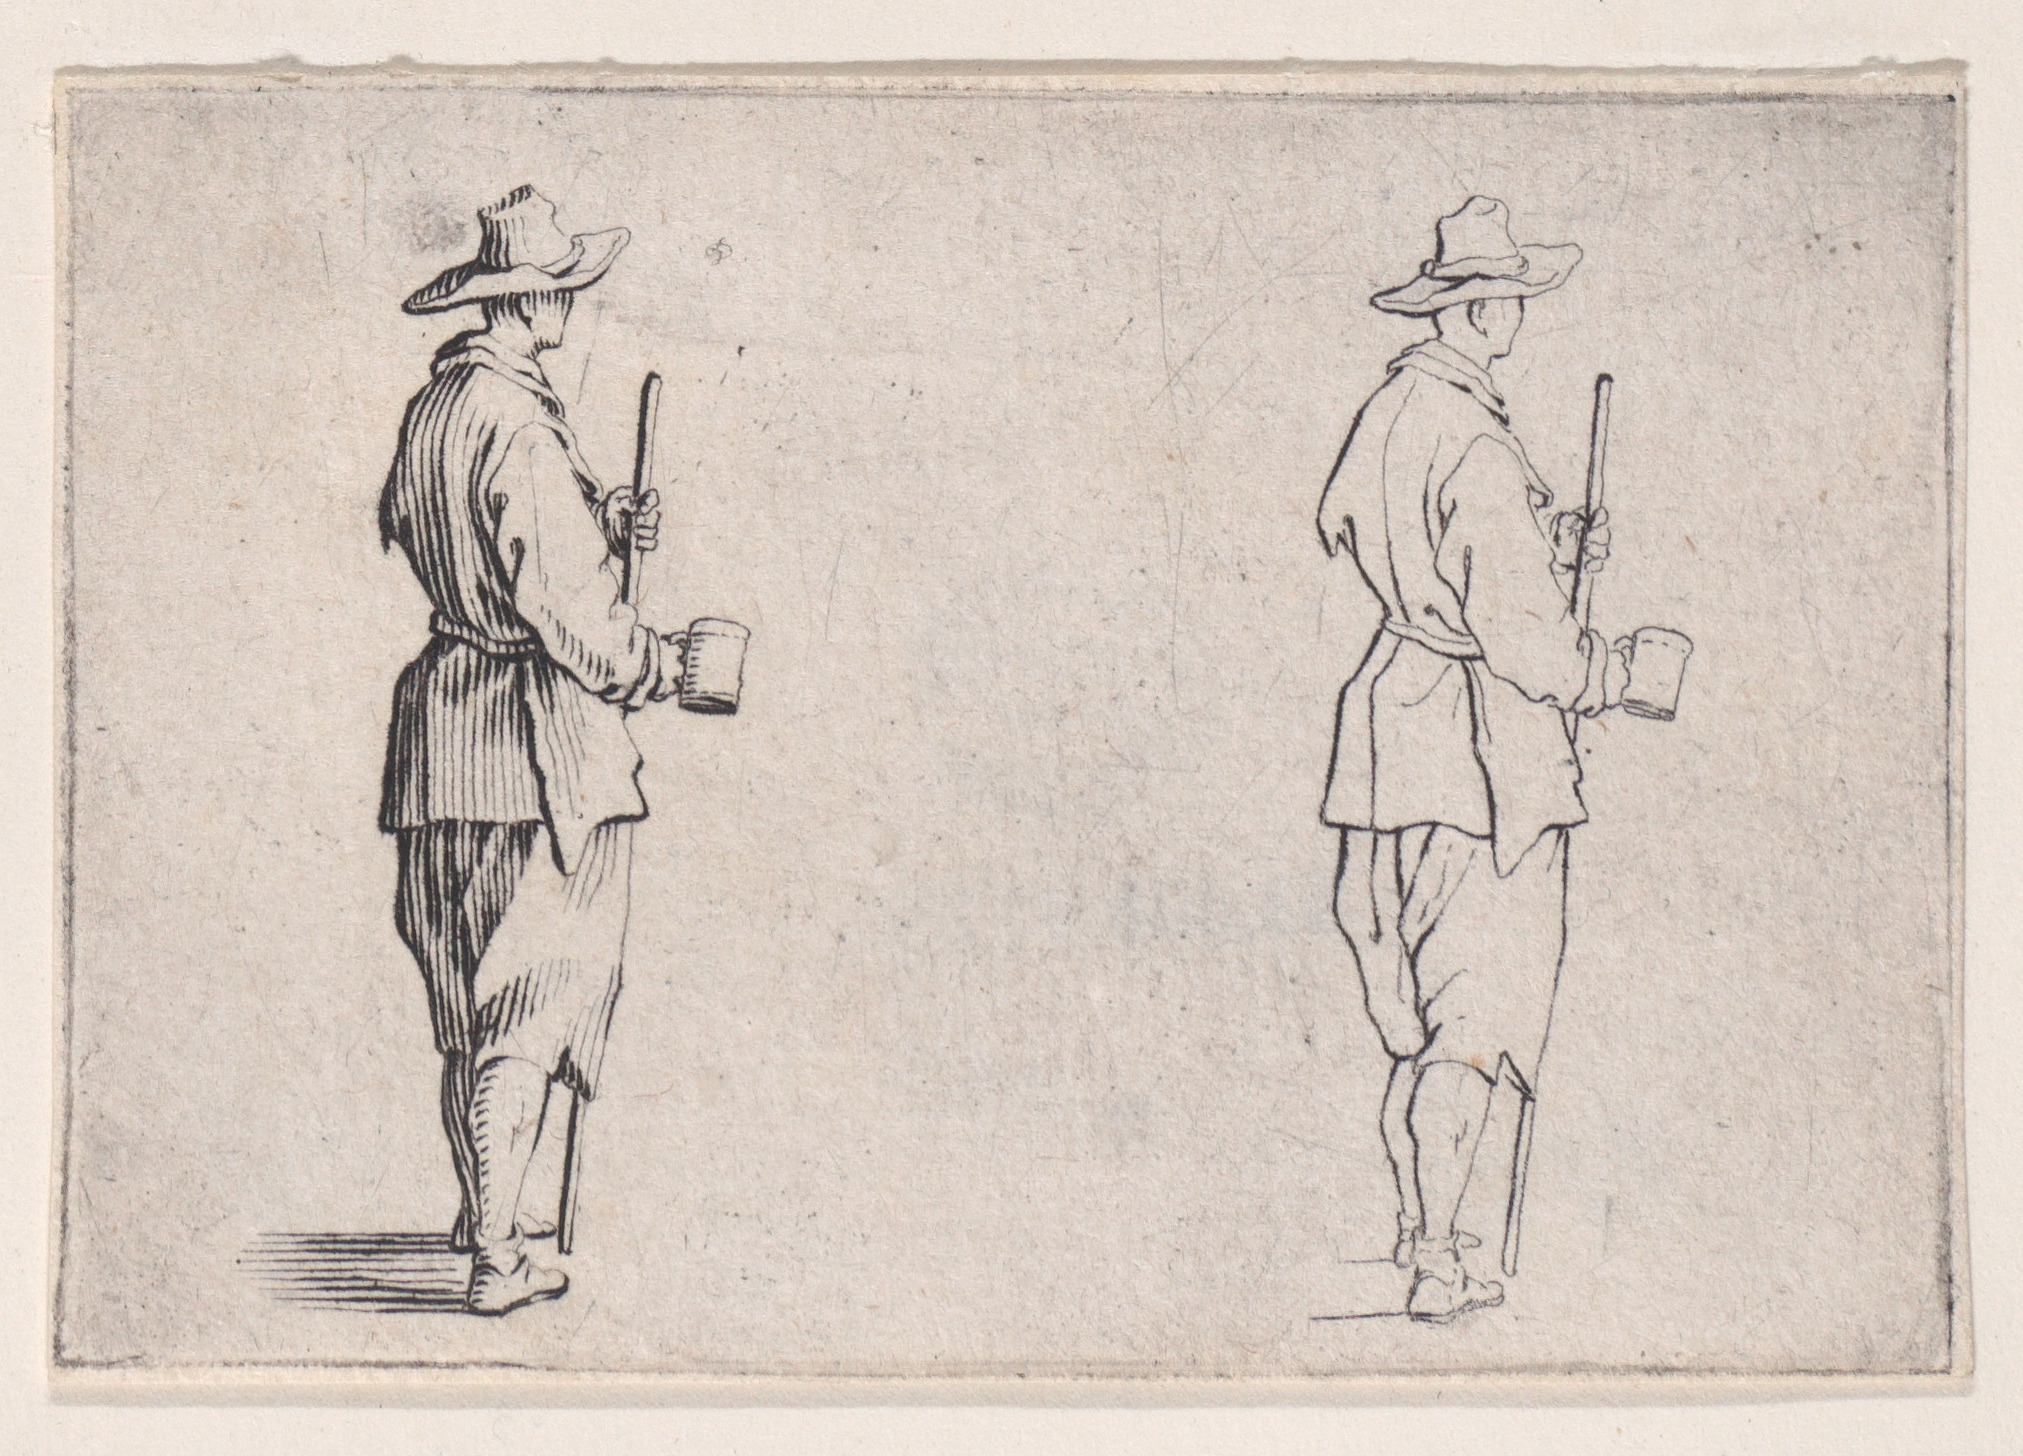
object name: print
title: Le Paysan Tenant un Gobelet (The Peasant Holding a Cup), from Les Caprices Series A, The Florence Set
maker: jacques callot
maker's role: artist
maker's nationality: french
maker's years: 1592-1635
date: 1617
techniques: etching